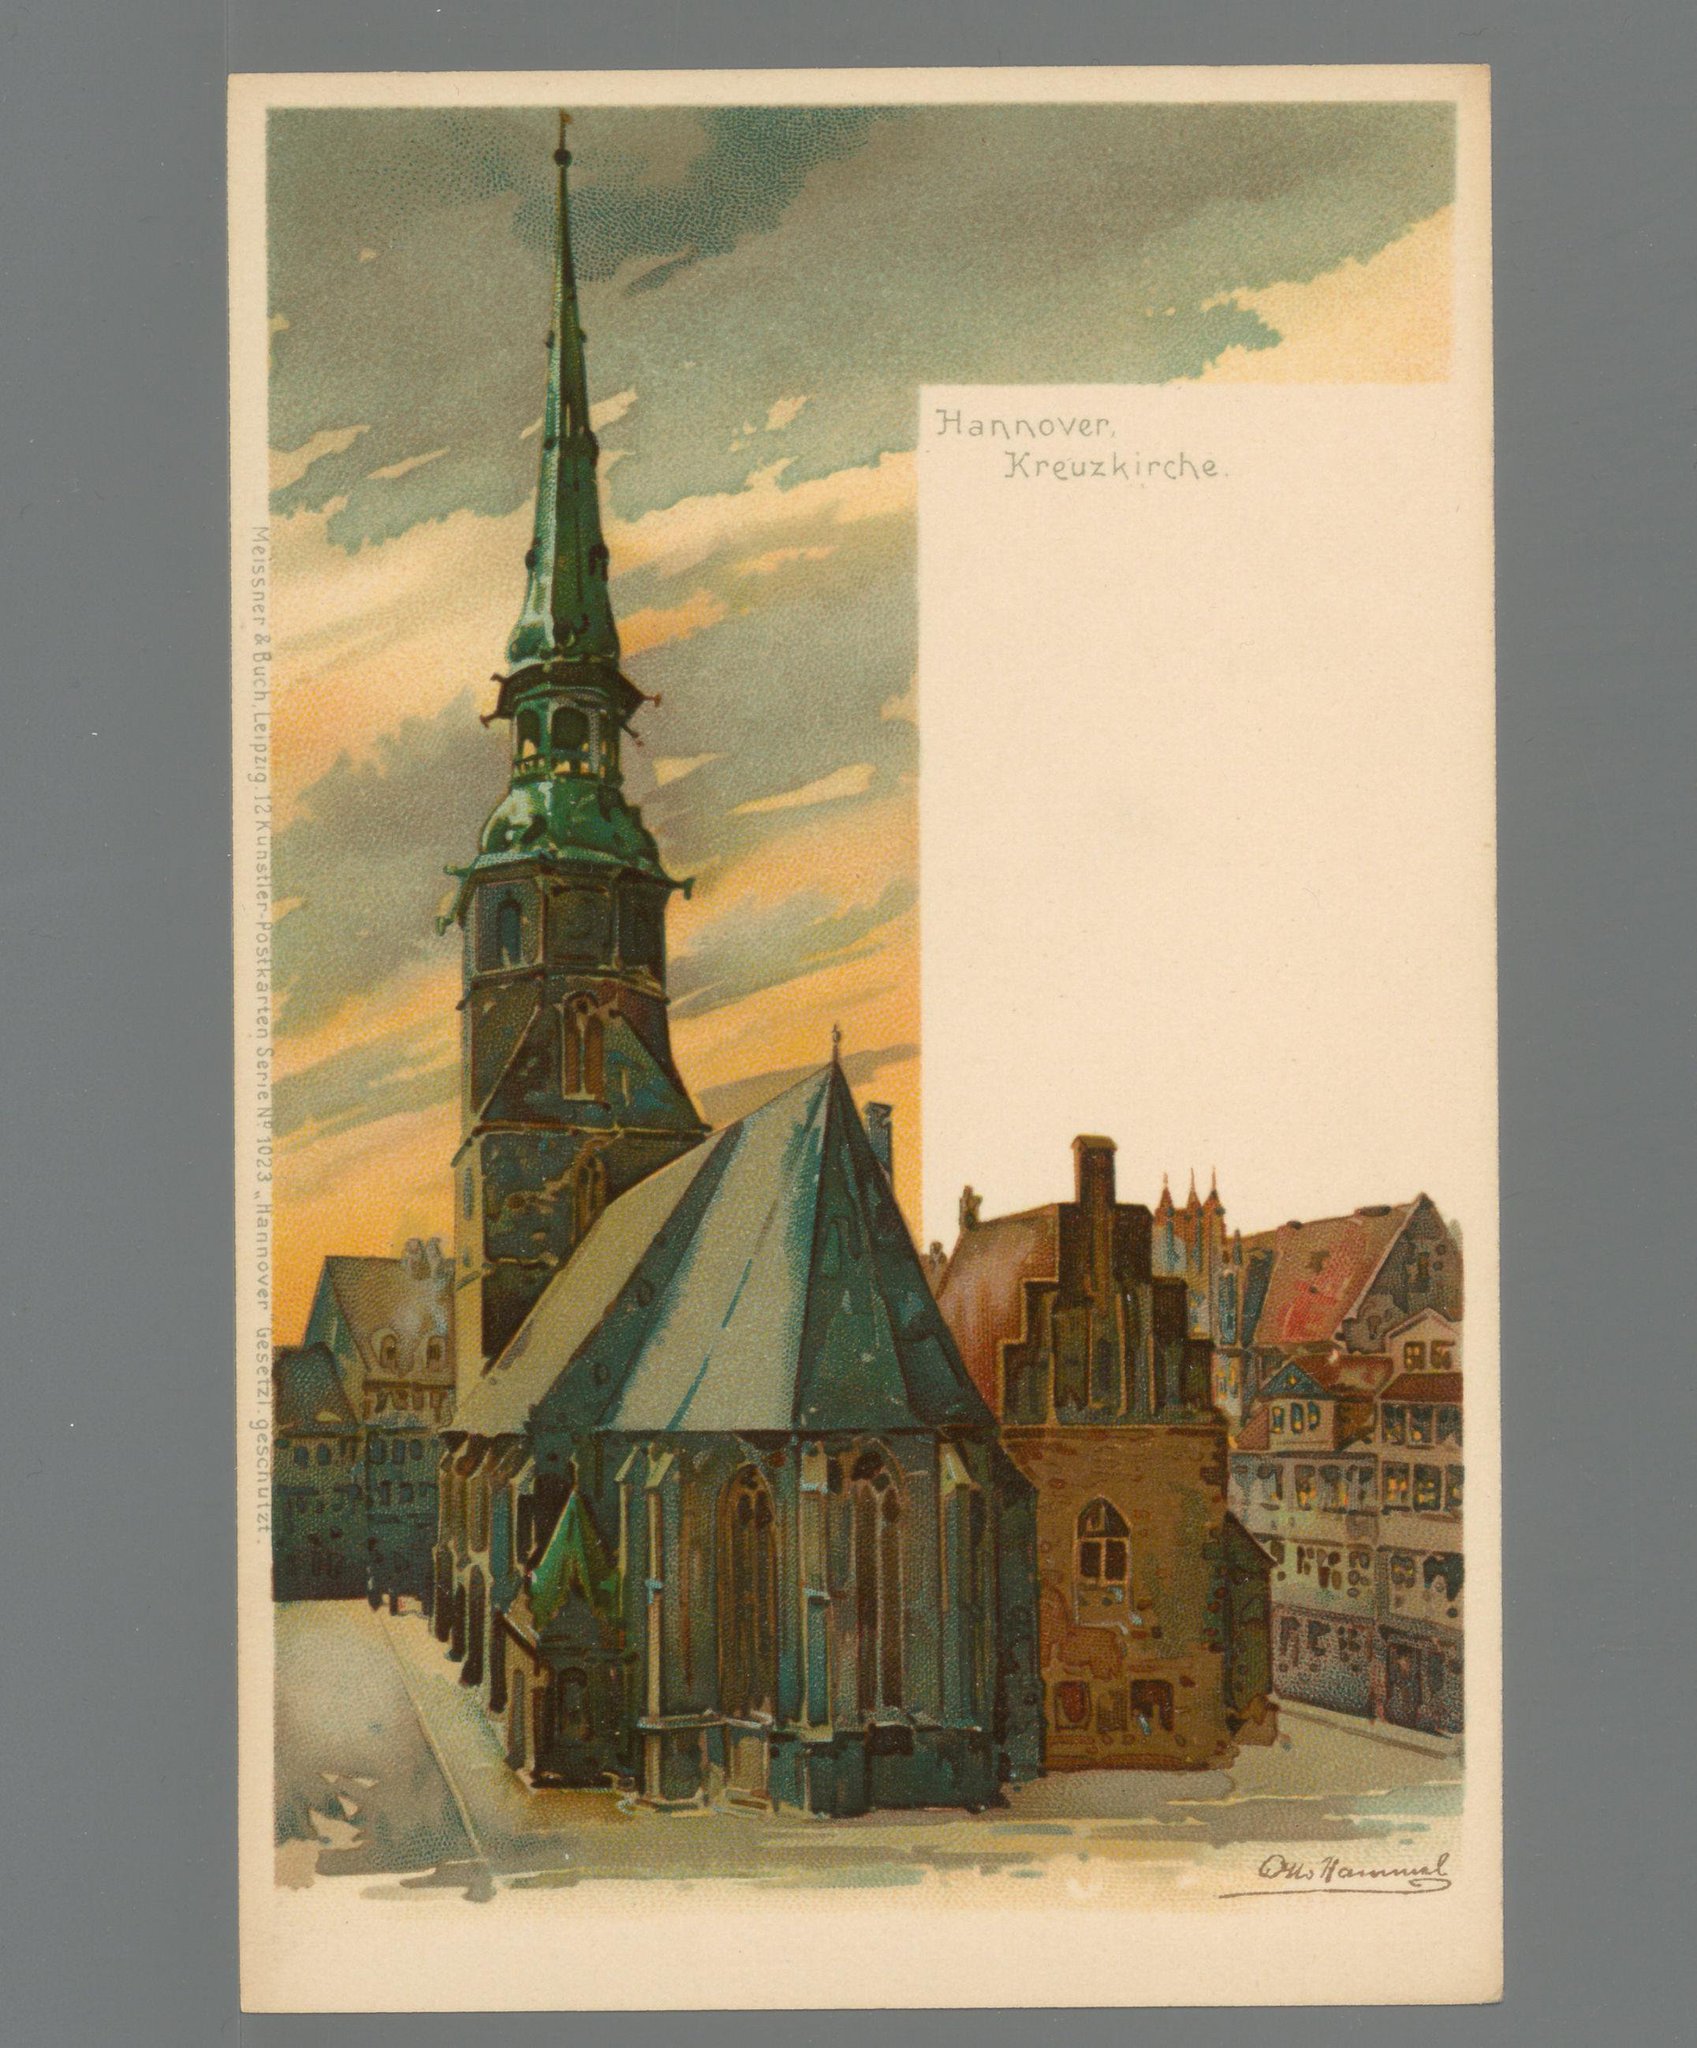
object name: reproduction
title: Hannover, Kreuzkirche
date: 1905-1930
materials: cardboard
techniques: lithograph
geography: leipzig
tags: church (exterior)